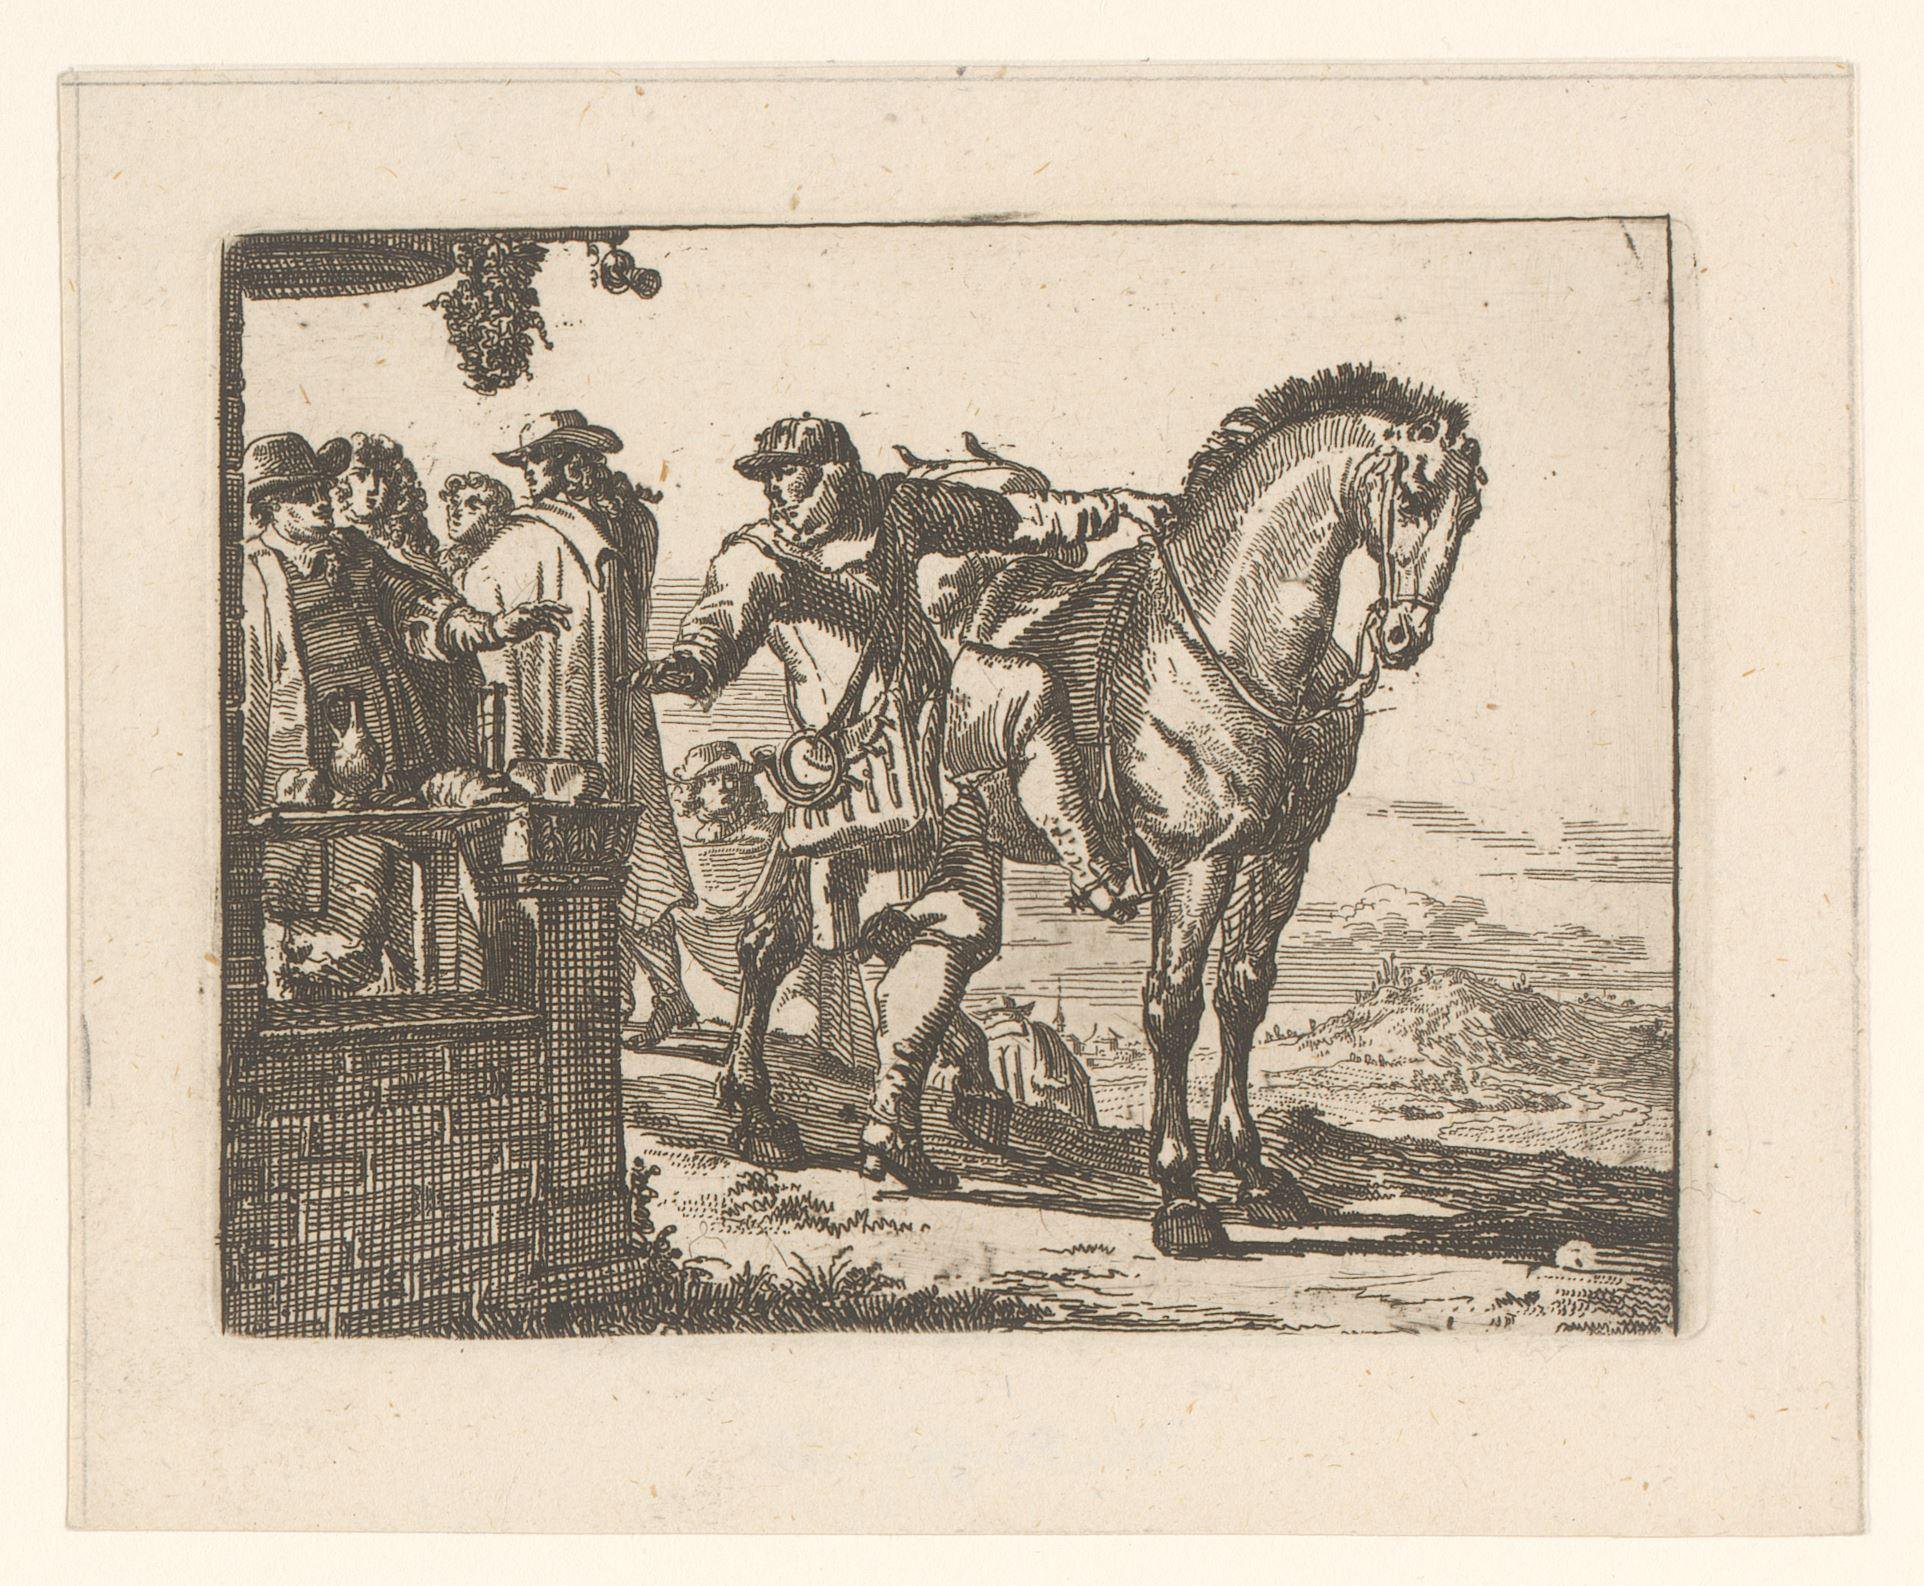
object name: print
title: Koerier stapt van zijn paard voor een herberg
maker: romeyn de hooghe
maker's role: draughtsman, goldsmith, painter, print maker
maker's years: 1645-1708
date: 1668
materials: paper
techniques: etching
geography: northern netherlands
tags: riding a horse, ass, or mule; rider, horseman, messenger, hotel, hostelry, inn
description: Prent met tekst in boekdruk op verso gebruikt in: Hoogstraten, Frans van. Het Voorhof der Ziele (...). Rotterdam: Frans van Hoogstraten, 1668. Ook gebruikt in de herdruk van 1698.